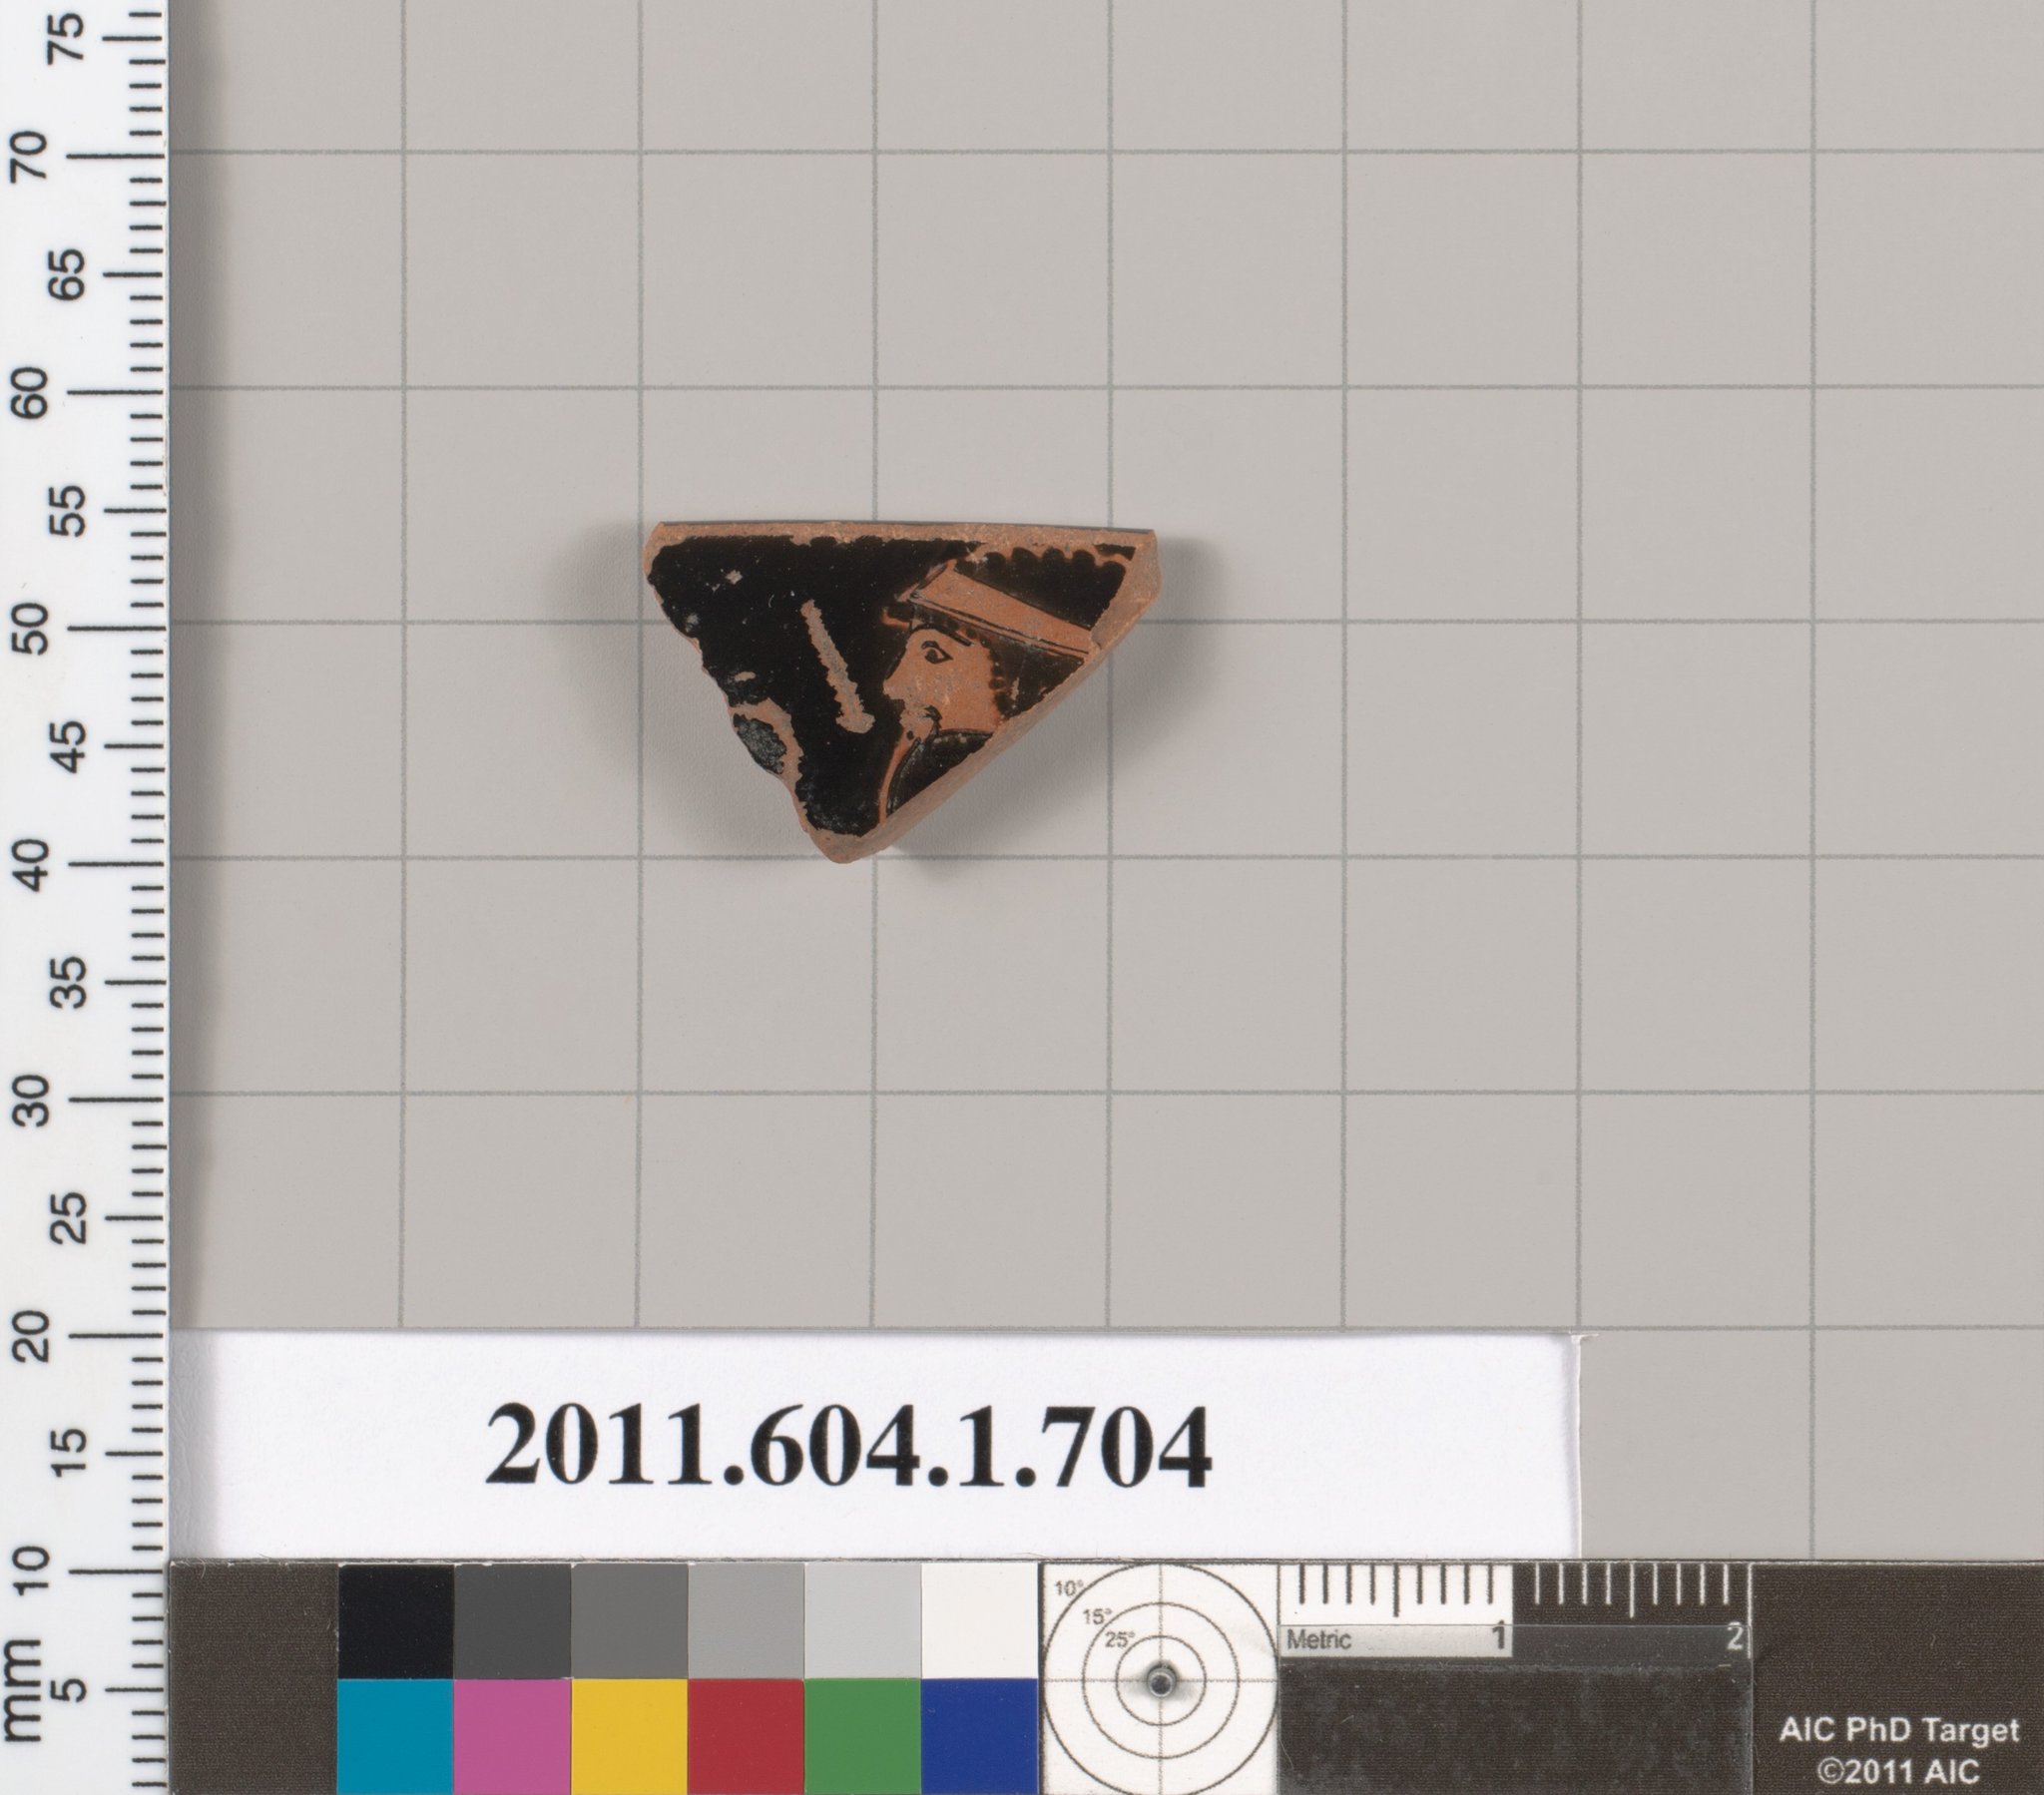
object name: kylix fragment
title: Terracotta rim fragment of a kylix (drinking cup)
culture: greek, attic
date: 490-480 BCE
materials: terracotta